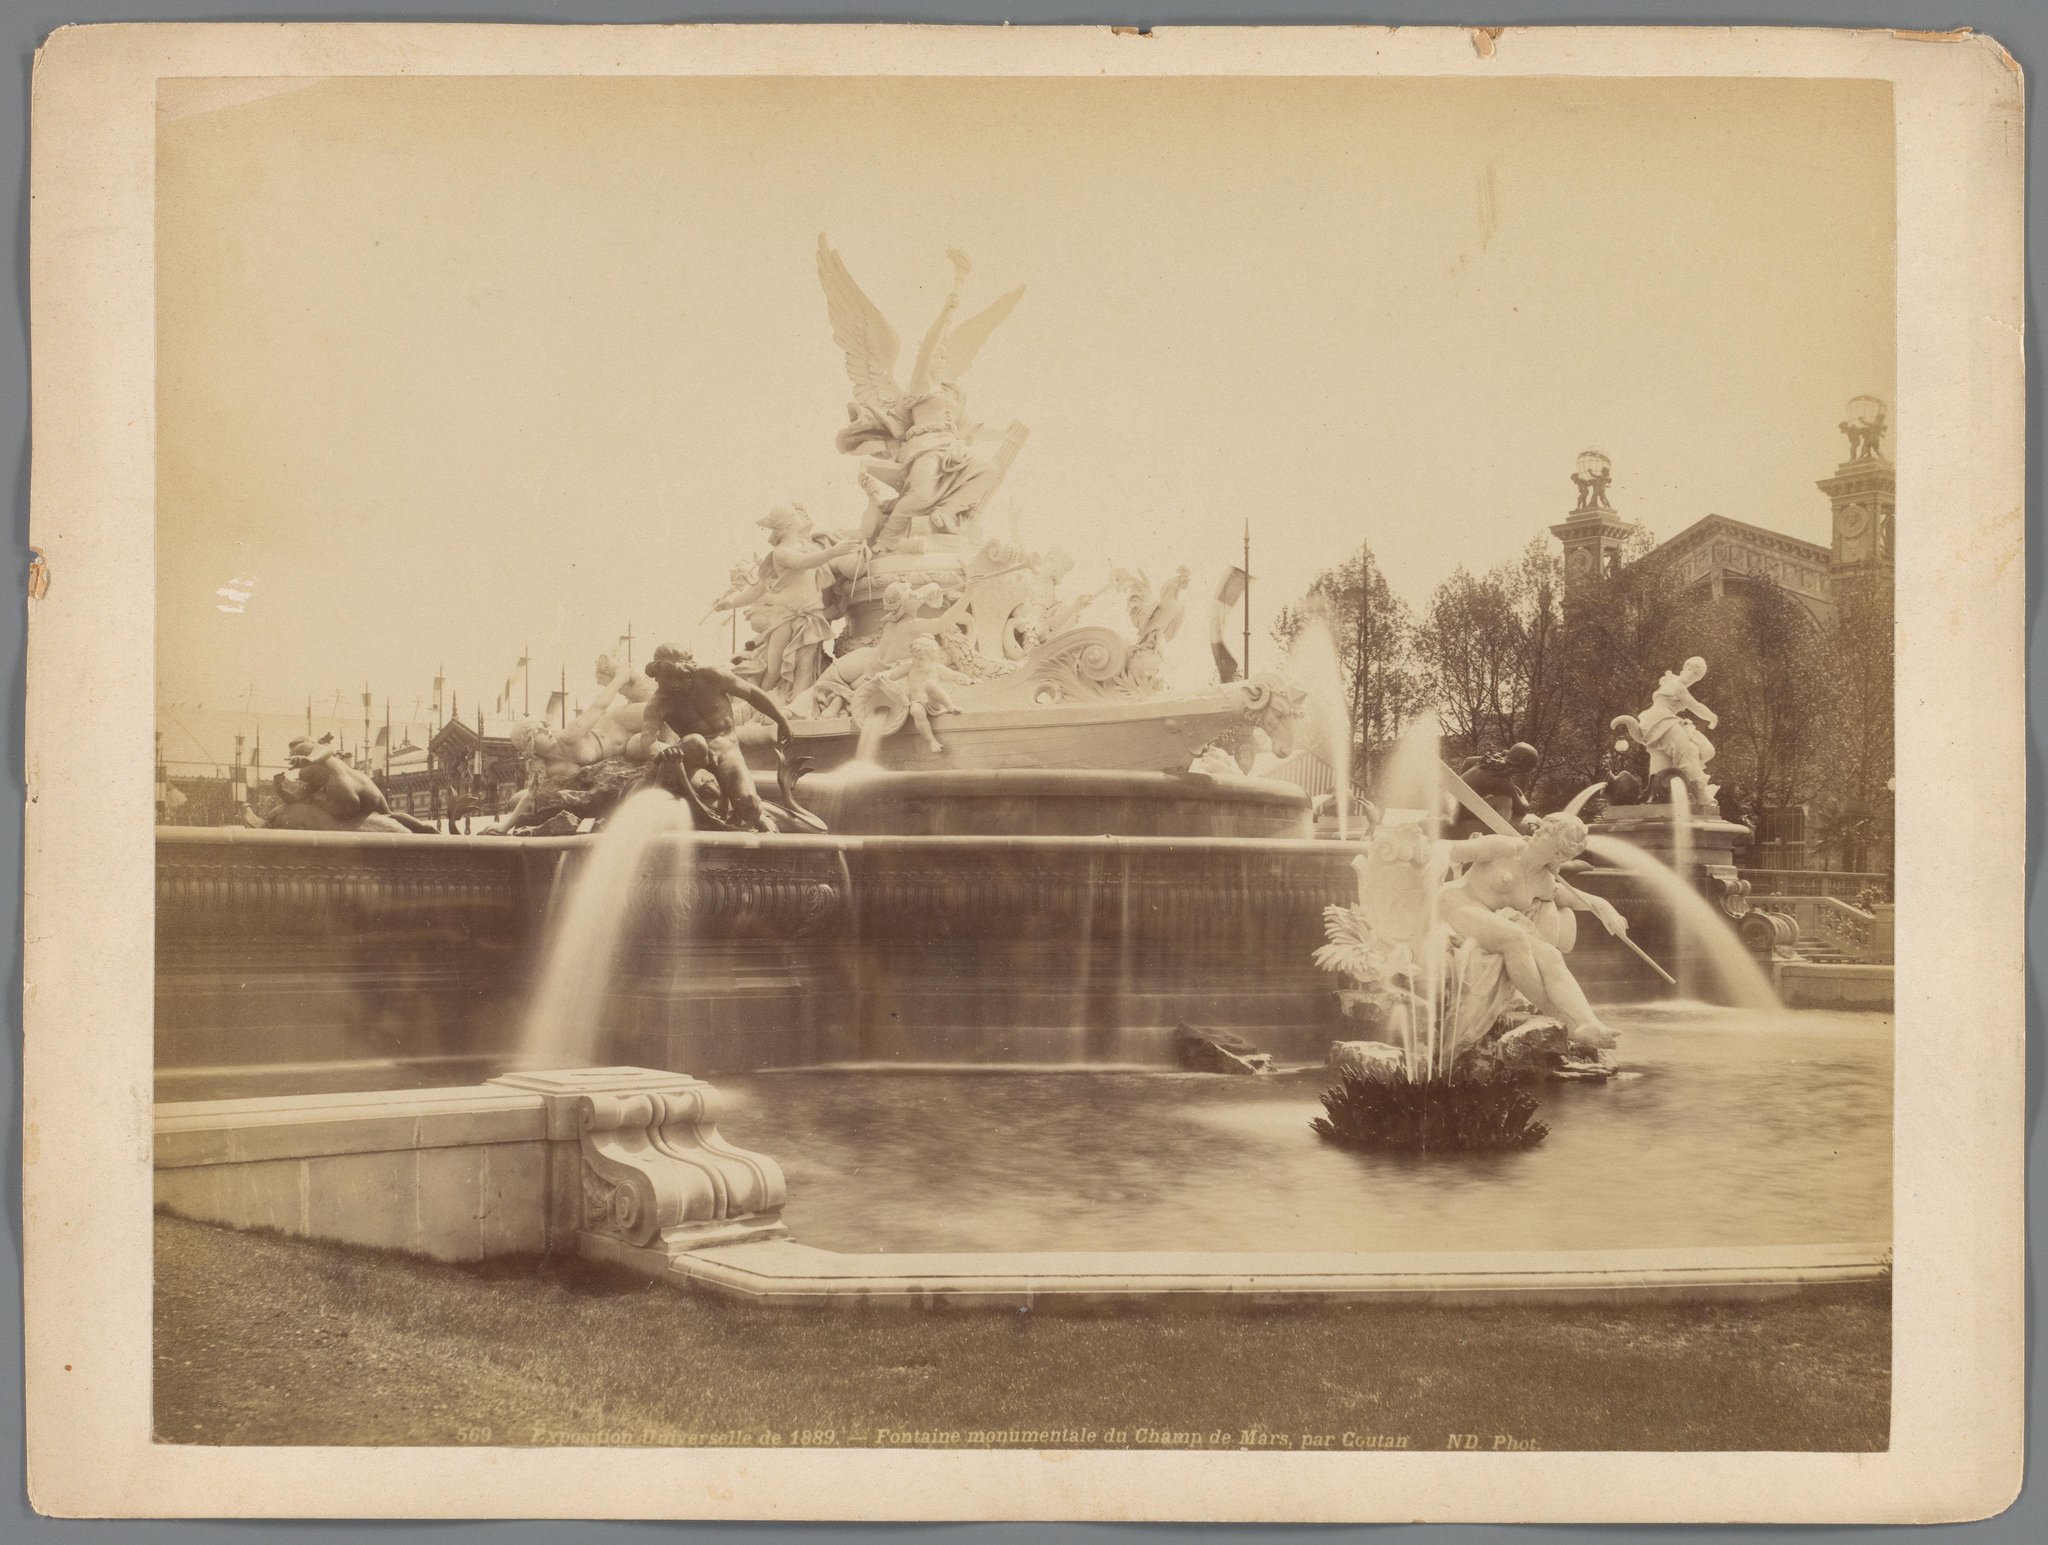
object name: photograph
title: Fontaine monumentale du Champ de Mars, par Coutan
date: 1889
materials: cardboard, paper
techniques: albumen print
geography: paris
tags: ornamental fountain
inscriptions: number: ‘569’